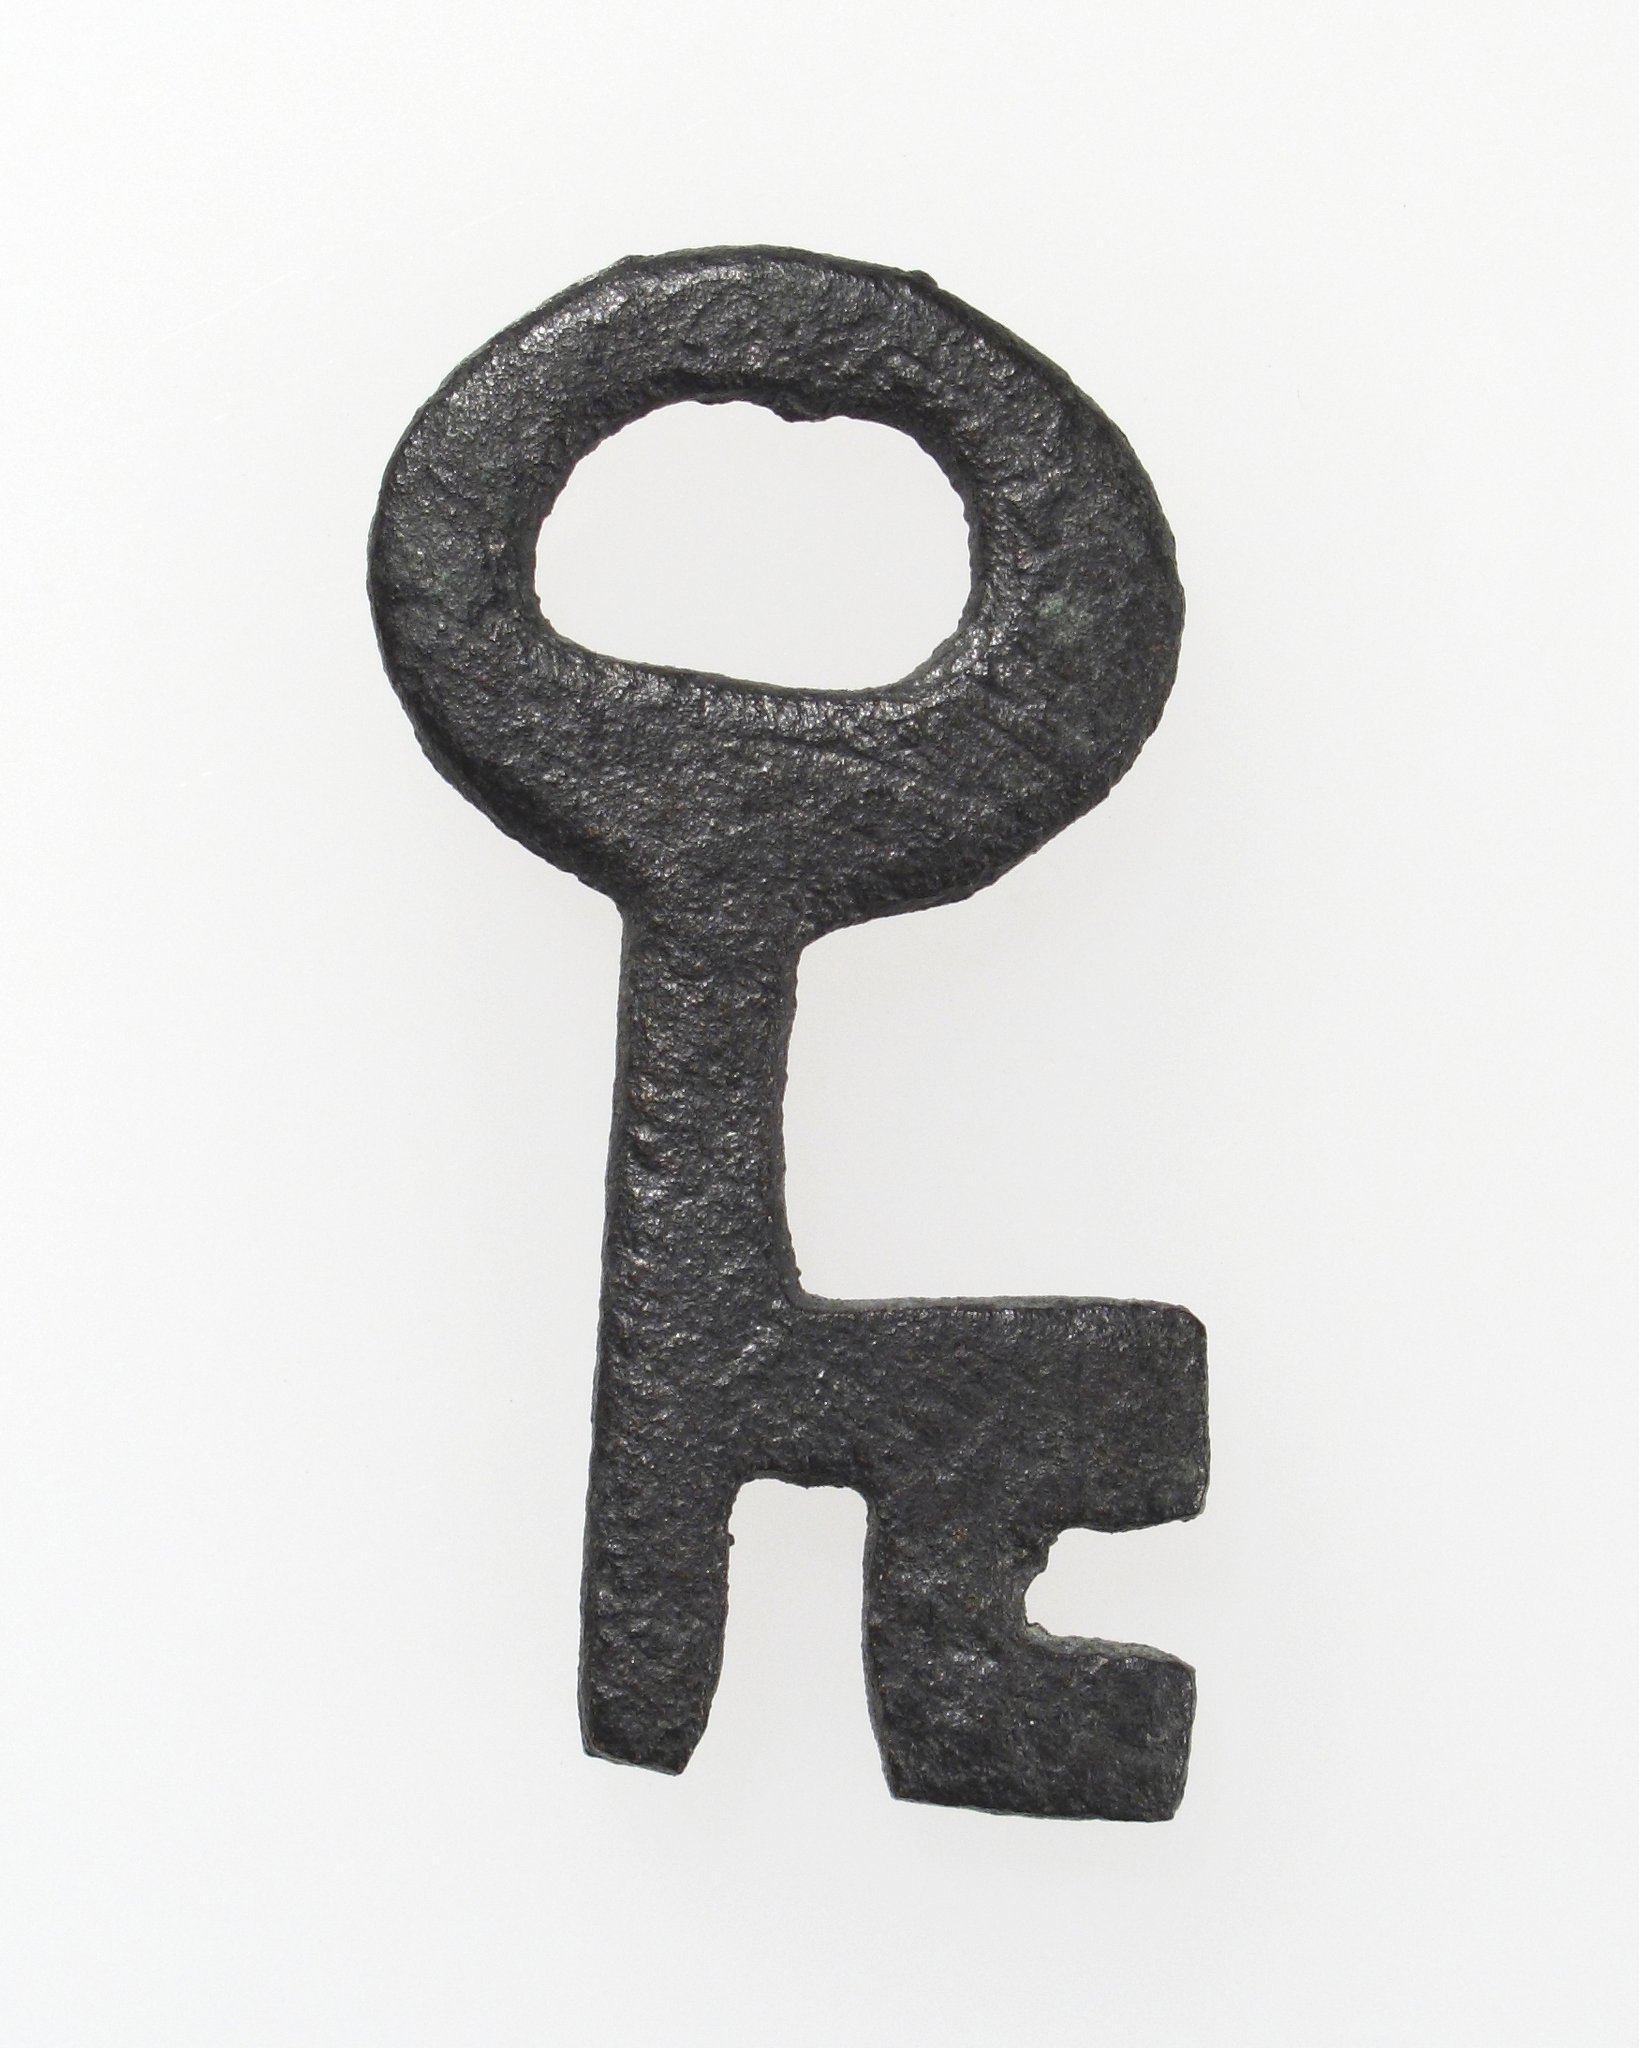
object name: pilgrim's badge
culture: french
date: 1301-1600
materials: lead